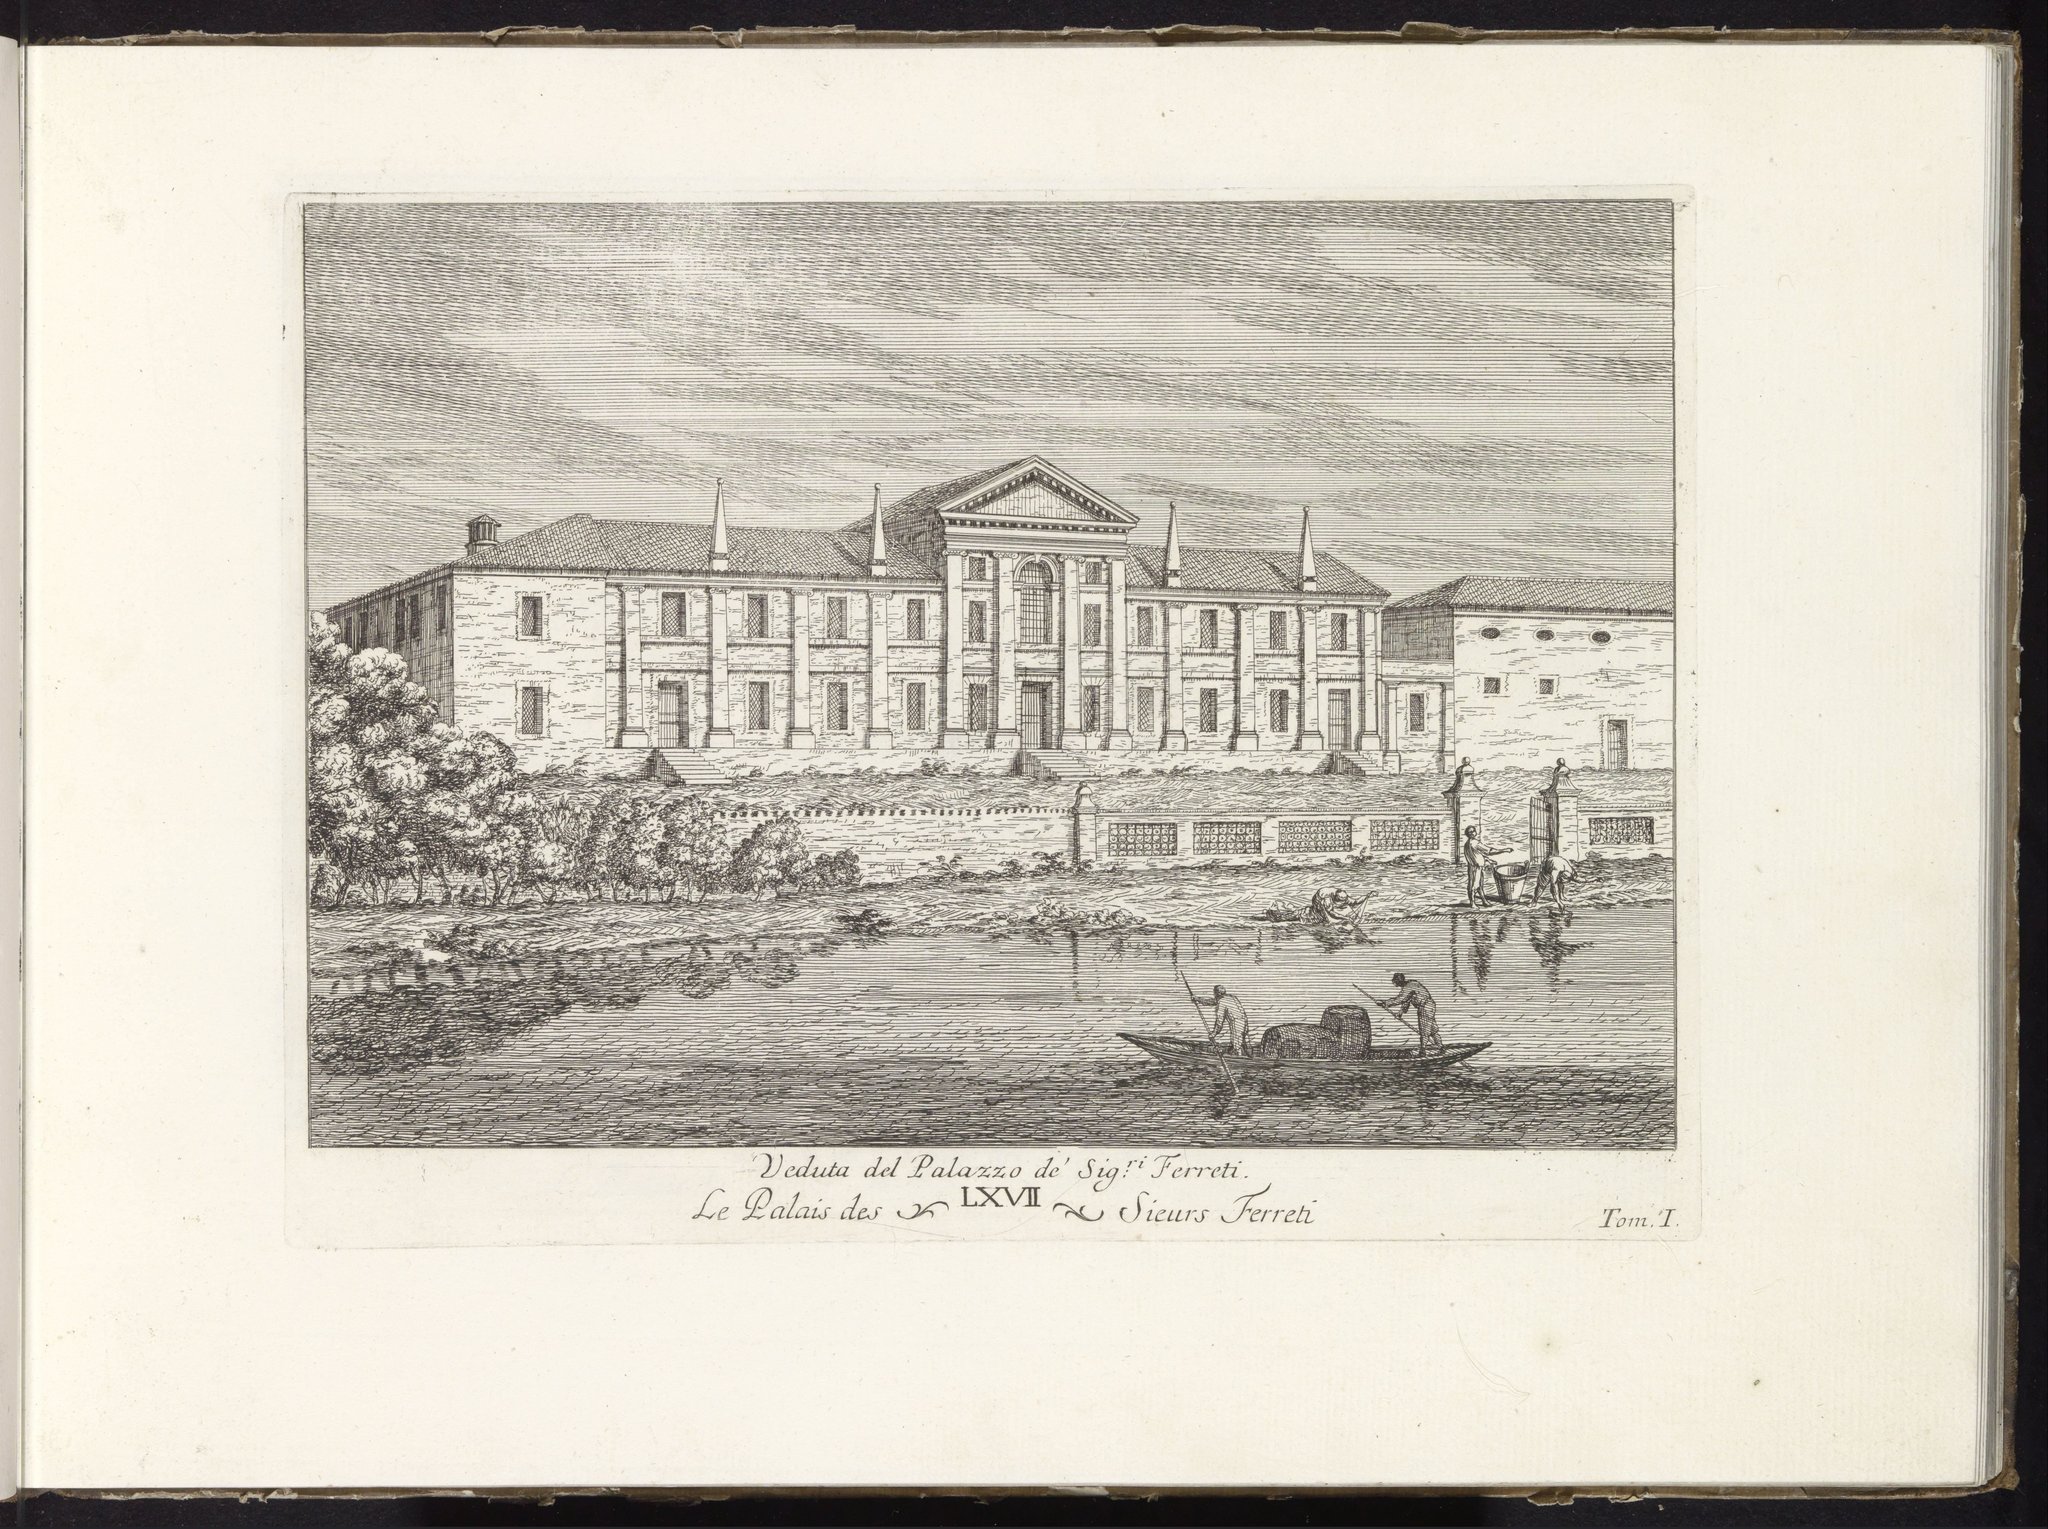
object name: print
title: Veduta del Palazzo de' Sig.ri Ferret (...)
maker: giovanni francesco costa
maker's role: draughtsman, painter, print maker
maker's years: -1773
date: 1750-1760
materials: paper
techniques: etching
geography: venice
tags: river, hôtel, i.e. small palace in city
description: Gezicht op Palazzo de' Signori Ferreti aan de rivier de Brenta. Genummerd midden onder: LXVII en rechtsonder: Tom: I. Deze prent maakt deel uit van een album.